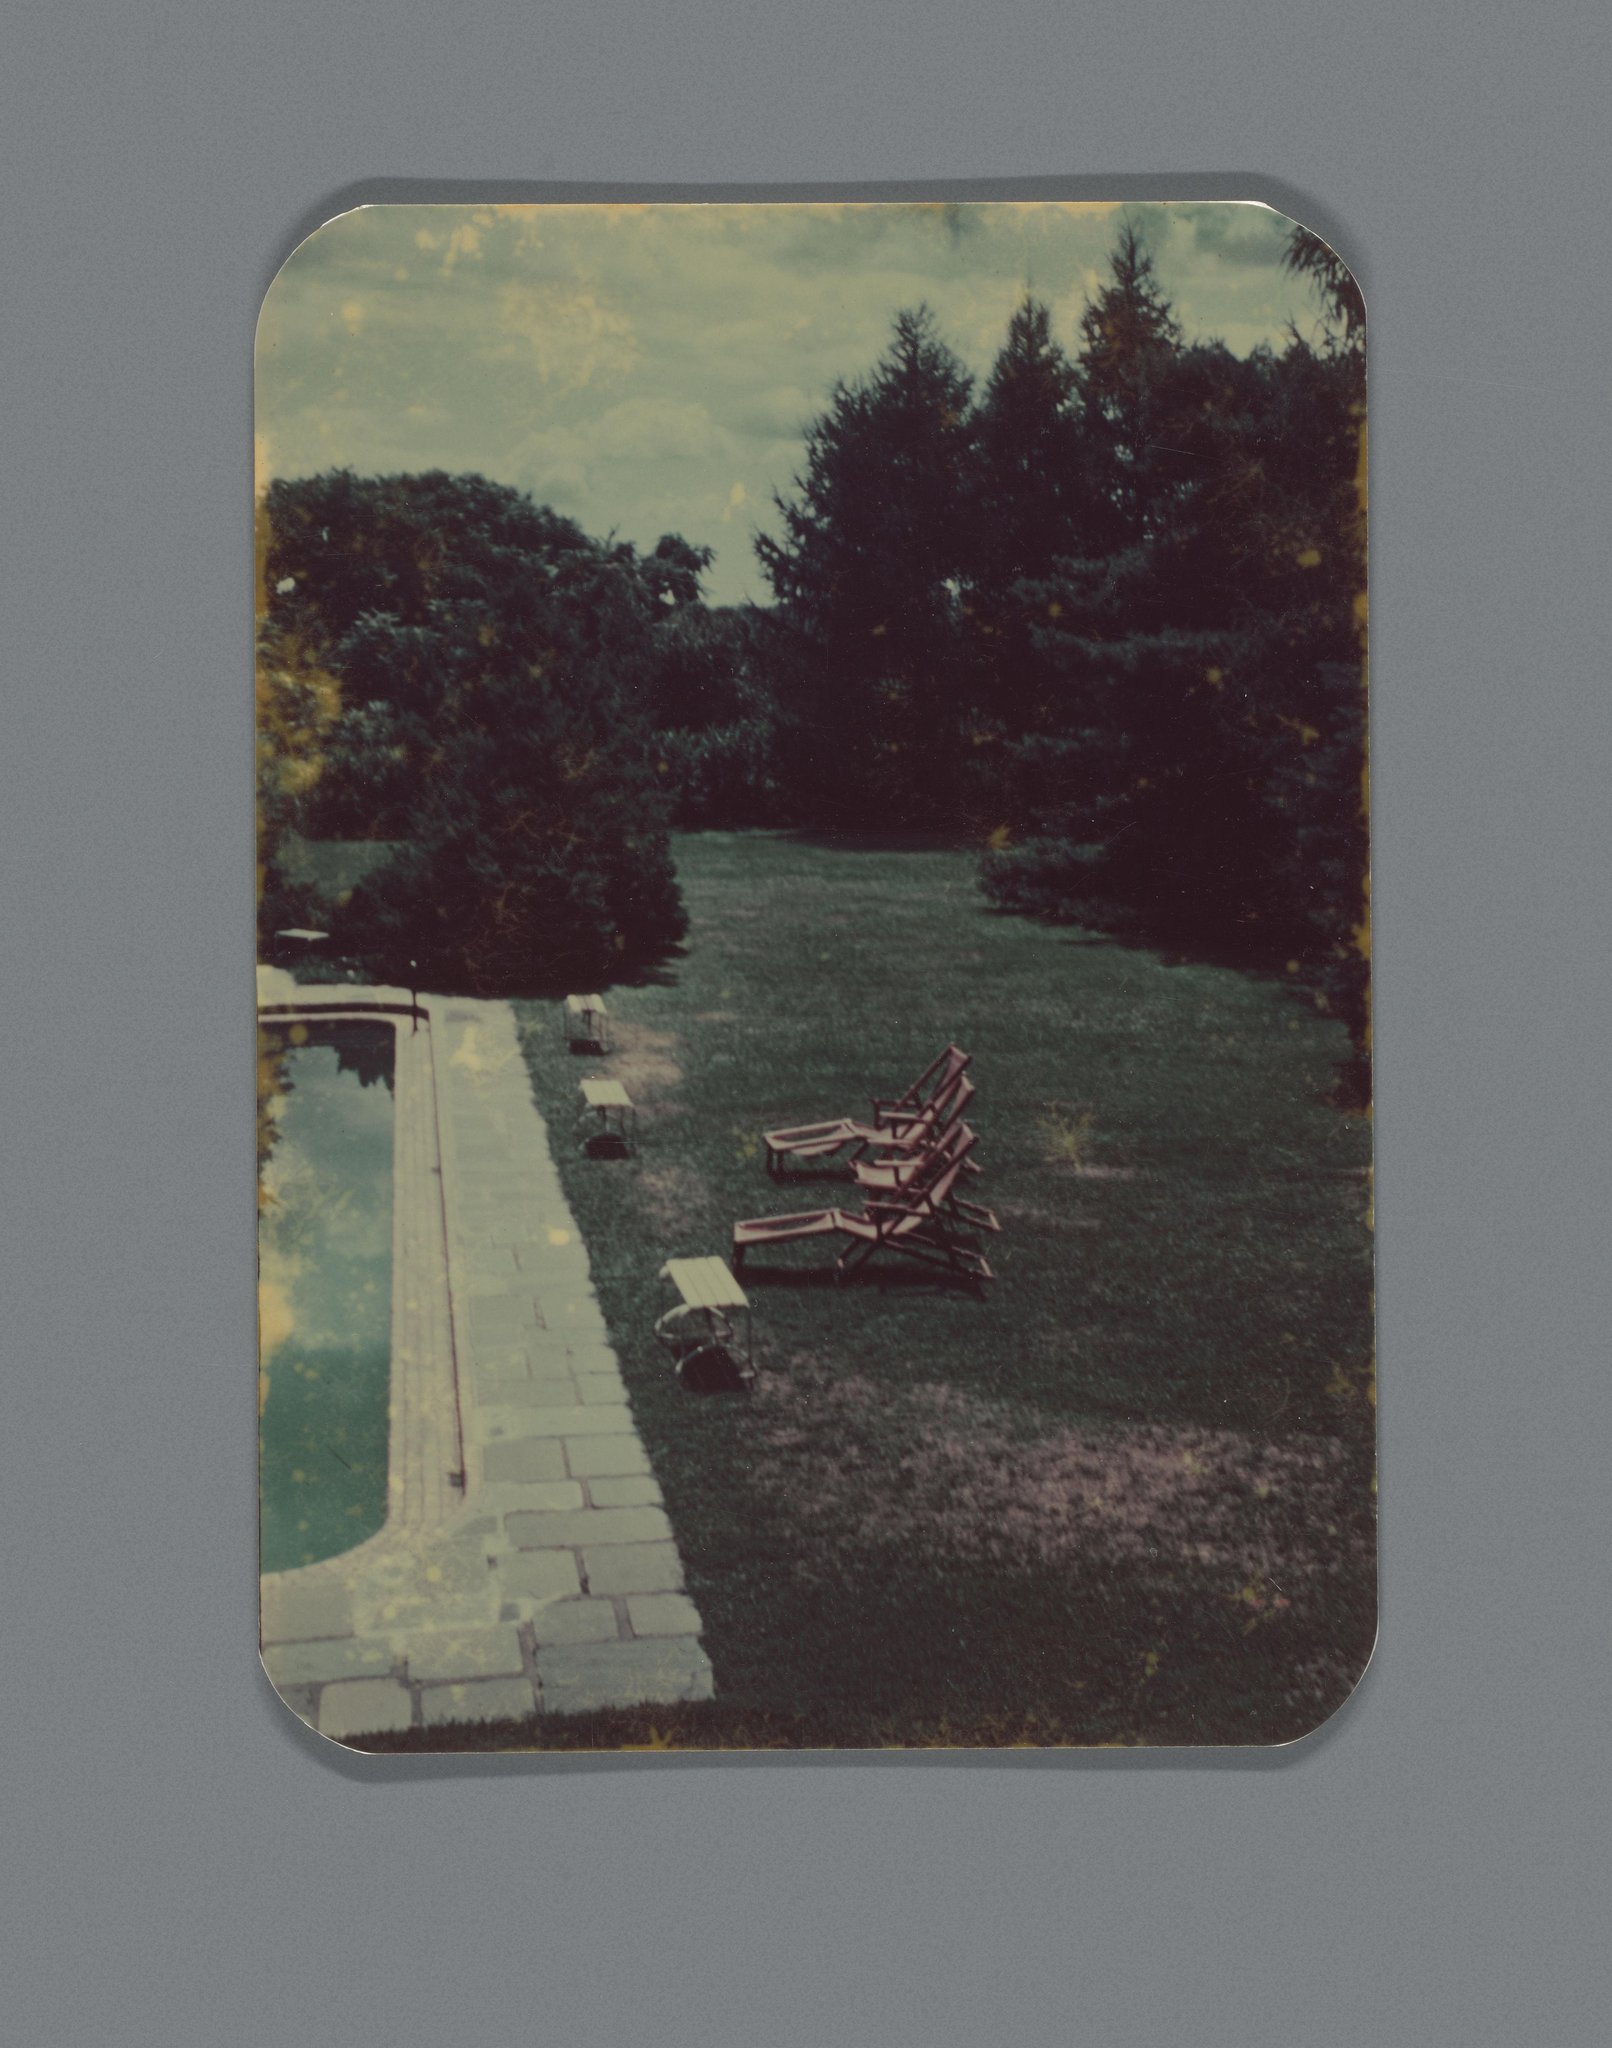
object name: photograph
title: Tuin met zwembad en tuinstoelen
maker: Anonymous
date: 1948-1955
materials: photographic support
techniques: chromogenic print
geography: united states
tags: united states of america